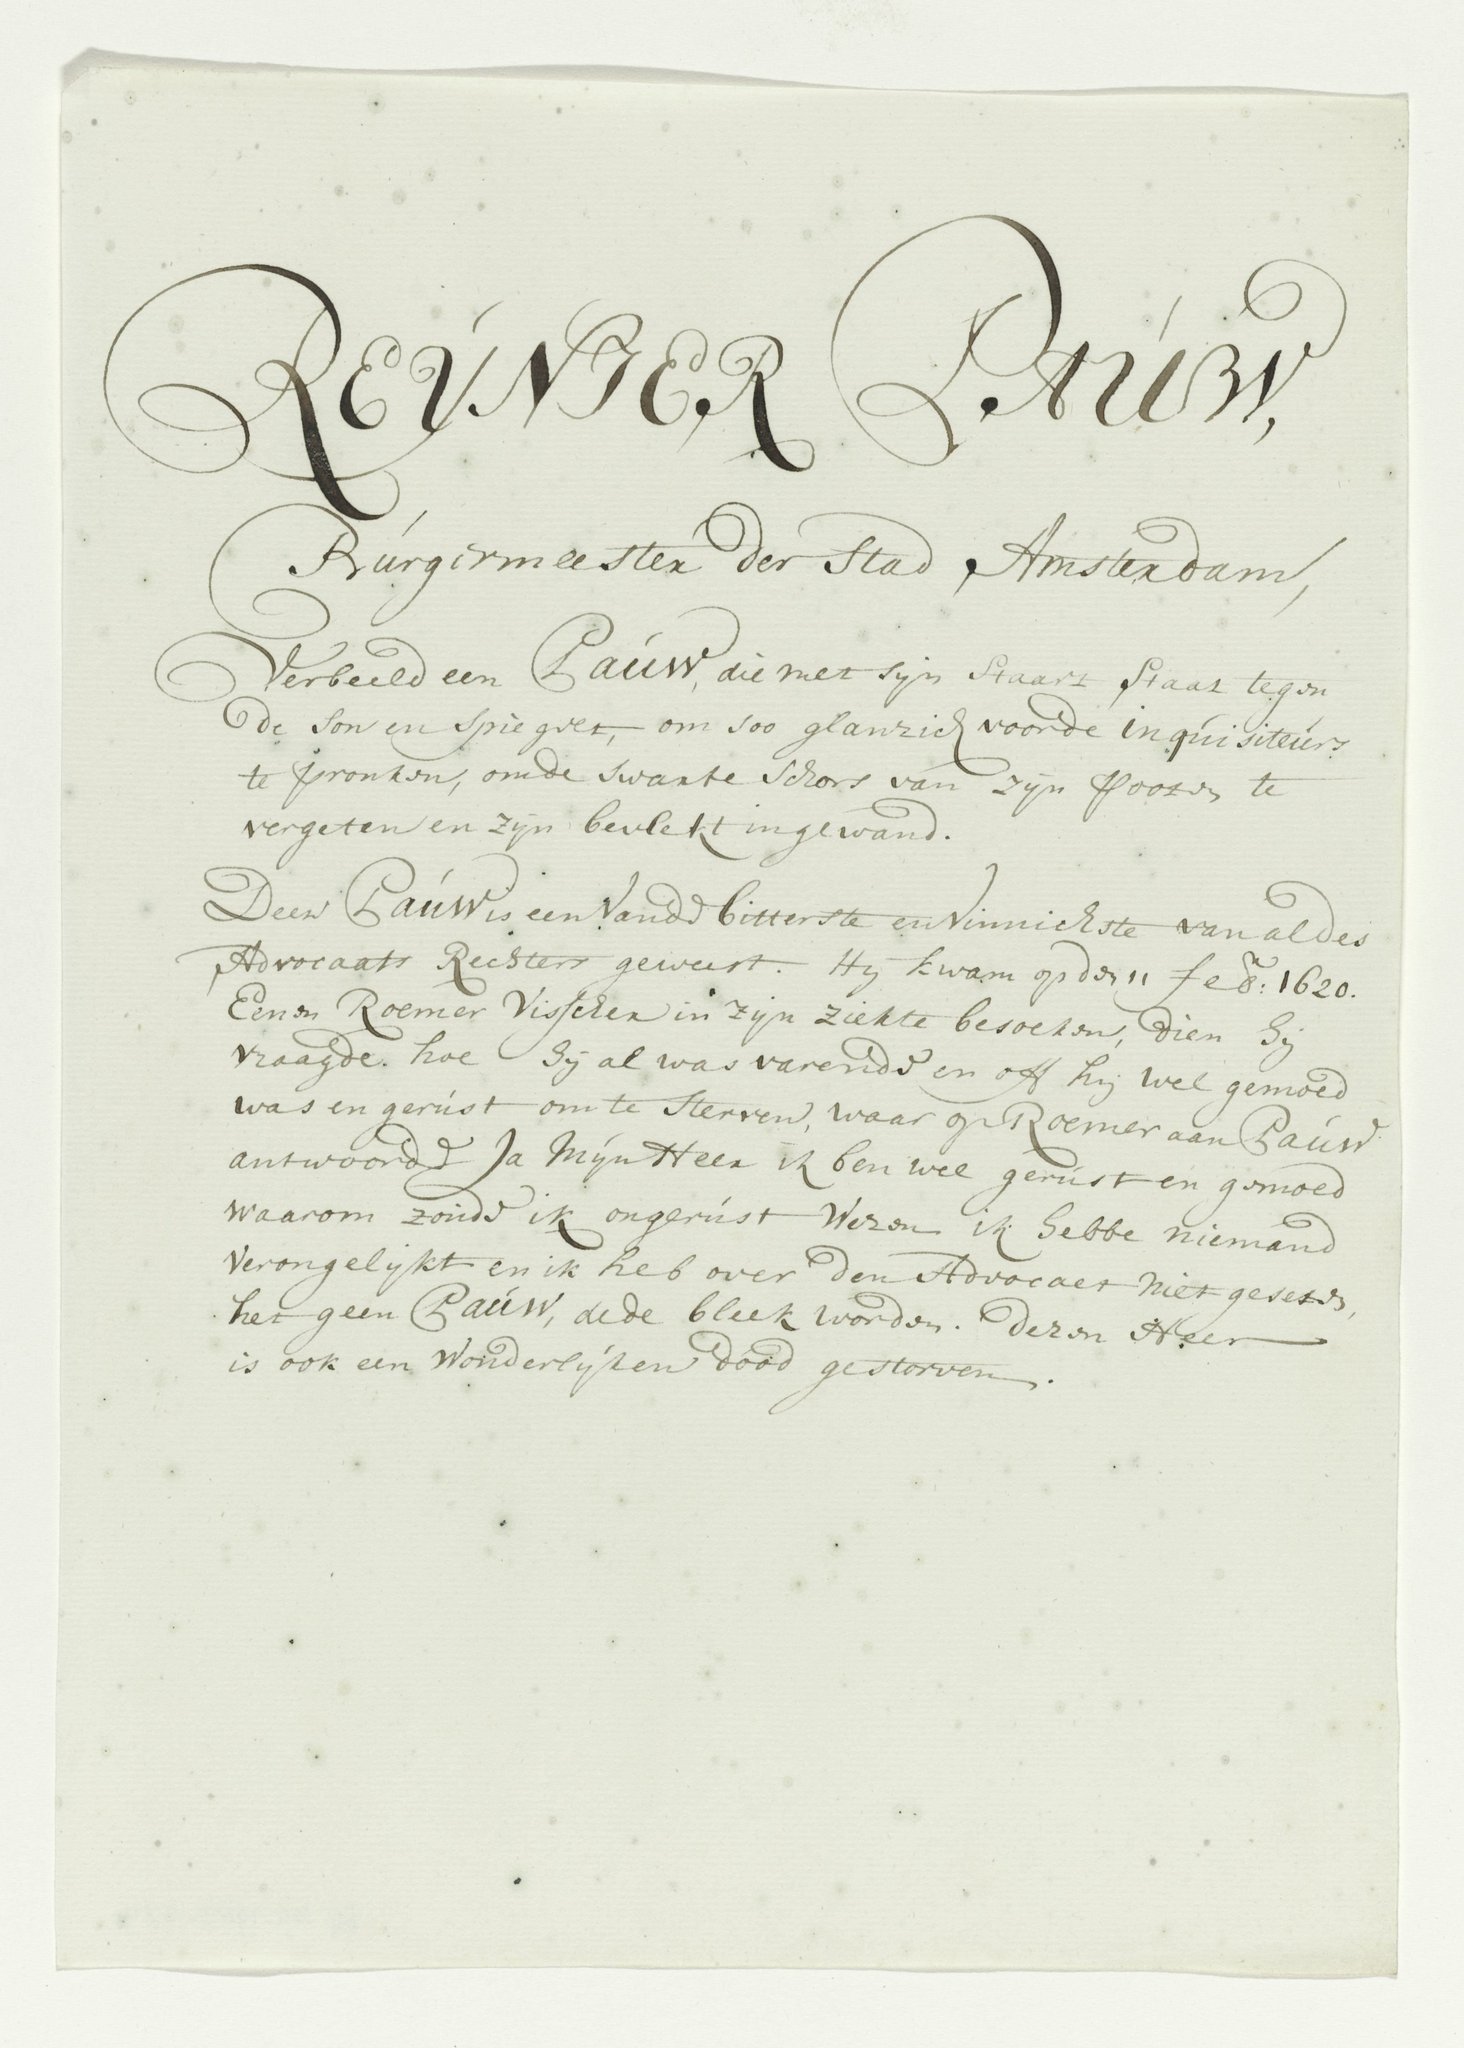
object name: manuscript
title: Regtspleging van Oldenbarnevelt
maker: Anonymous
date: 1710-1720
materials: paper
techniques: pen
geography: netherlands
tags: the hague, johan van oldenbarnevelt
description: Spotprent van Reynier Pauw, rechter van Van Oldenbarnevelt; pauw met uitgespreide staart, in krans van bloemen en bladeren. Daaronder cartouche waarin naam en daarboven nr. 12. Behorende bij serie aquarellen in boek.